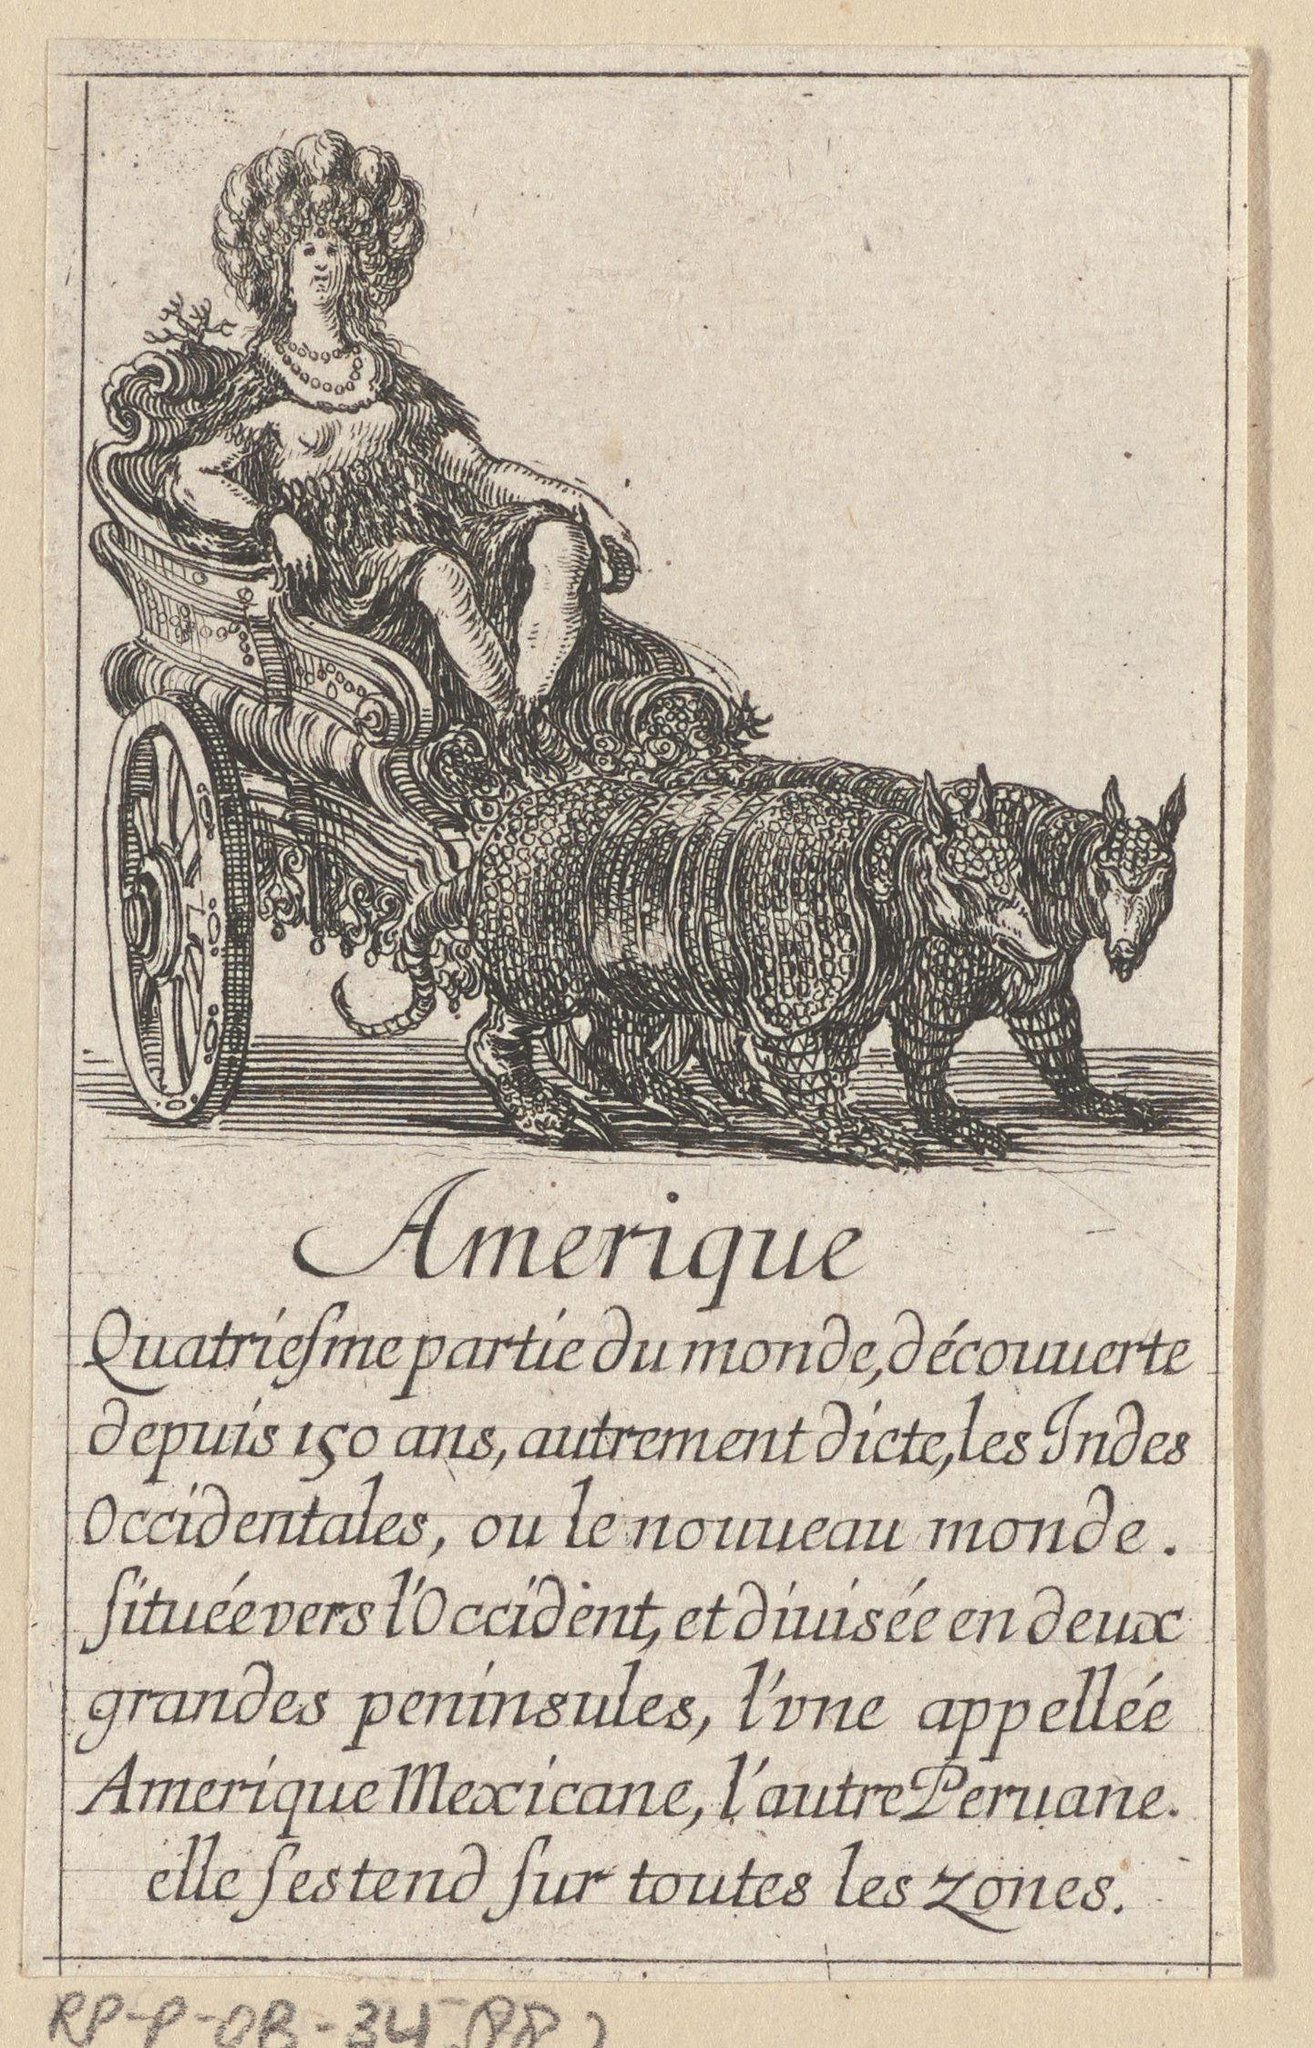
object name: print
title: Amerique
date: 1620-1664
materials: paper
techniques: etching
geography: paris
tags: america represented allegorically; 'america' (ripa), native peoples of the americas (+ costume), other mammals: armadillo, two-wheeled vehicle drawn by two animals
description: Deze prent maakt deel uit van een kaartspel met 52 kaarten met voorstellingen van vrouwen uit landen over de hele wereld. De serie is uitgedacht door Jean Desmarests de Saint-Sorlin in opdracht van Kardinaal Mazarin. Het kaartspel werd gemaakt voor de jonge Lodewijk XIV, samen met het Jeu des Fables, Jeu des Reynes Renommées en Jeu des Rois de France. Getekende voorstudie wordt bewaard in Musée du Louvre te Parijs (inv. nr. 457).